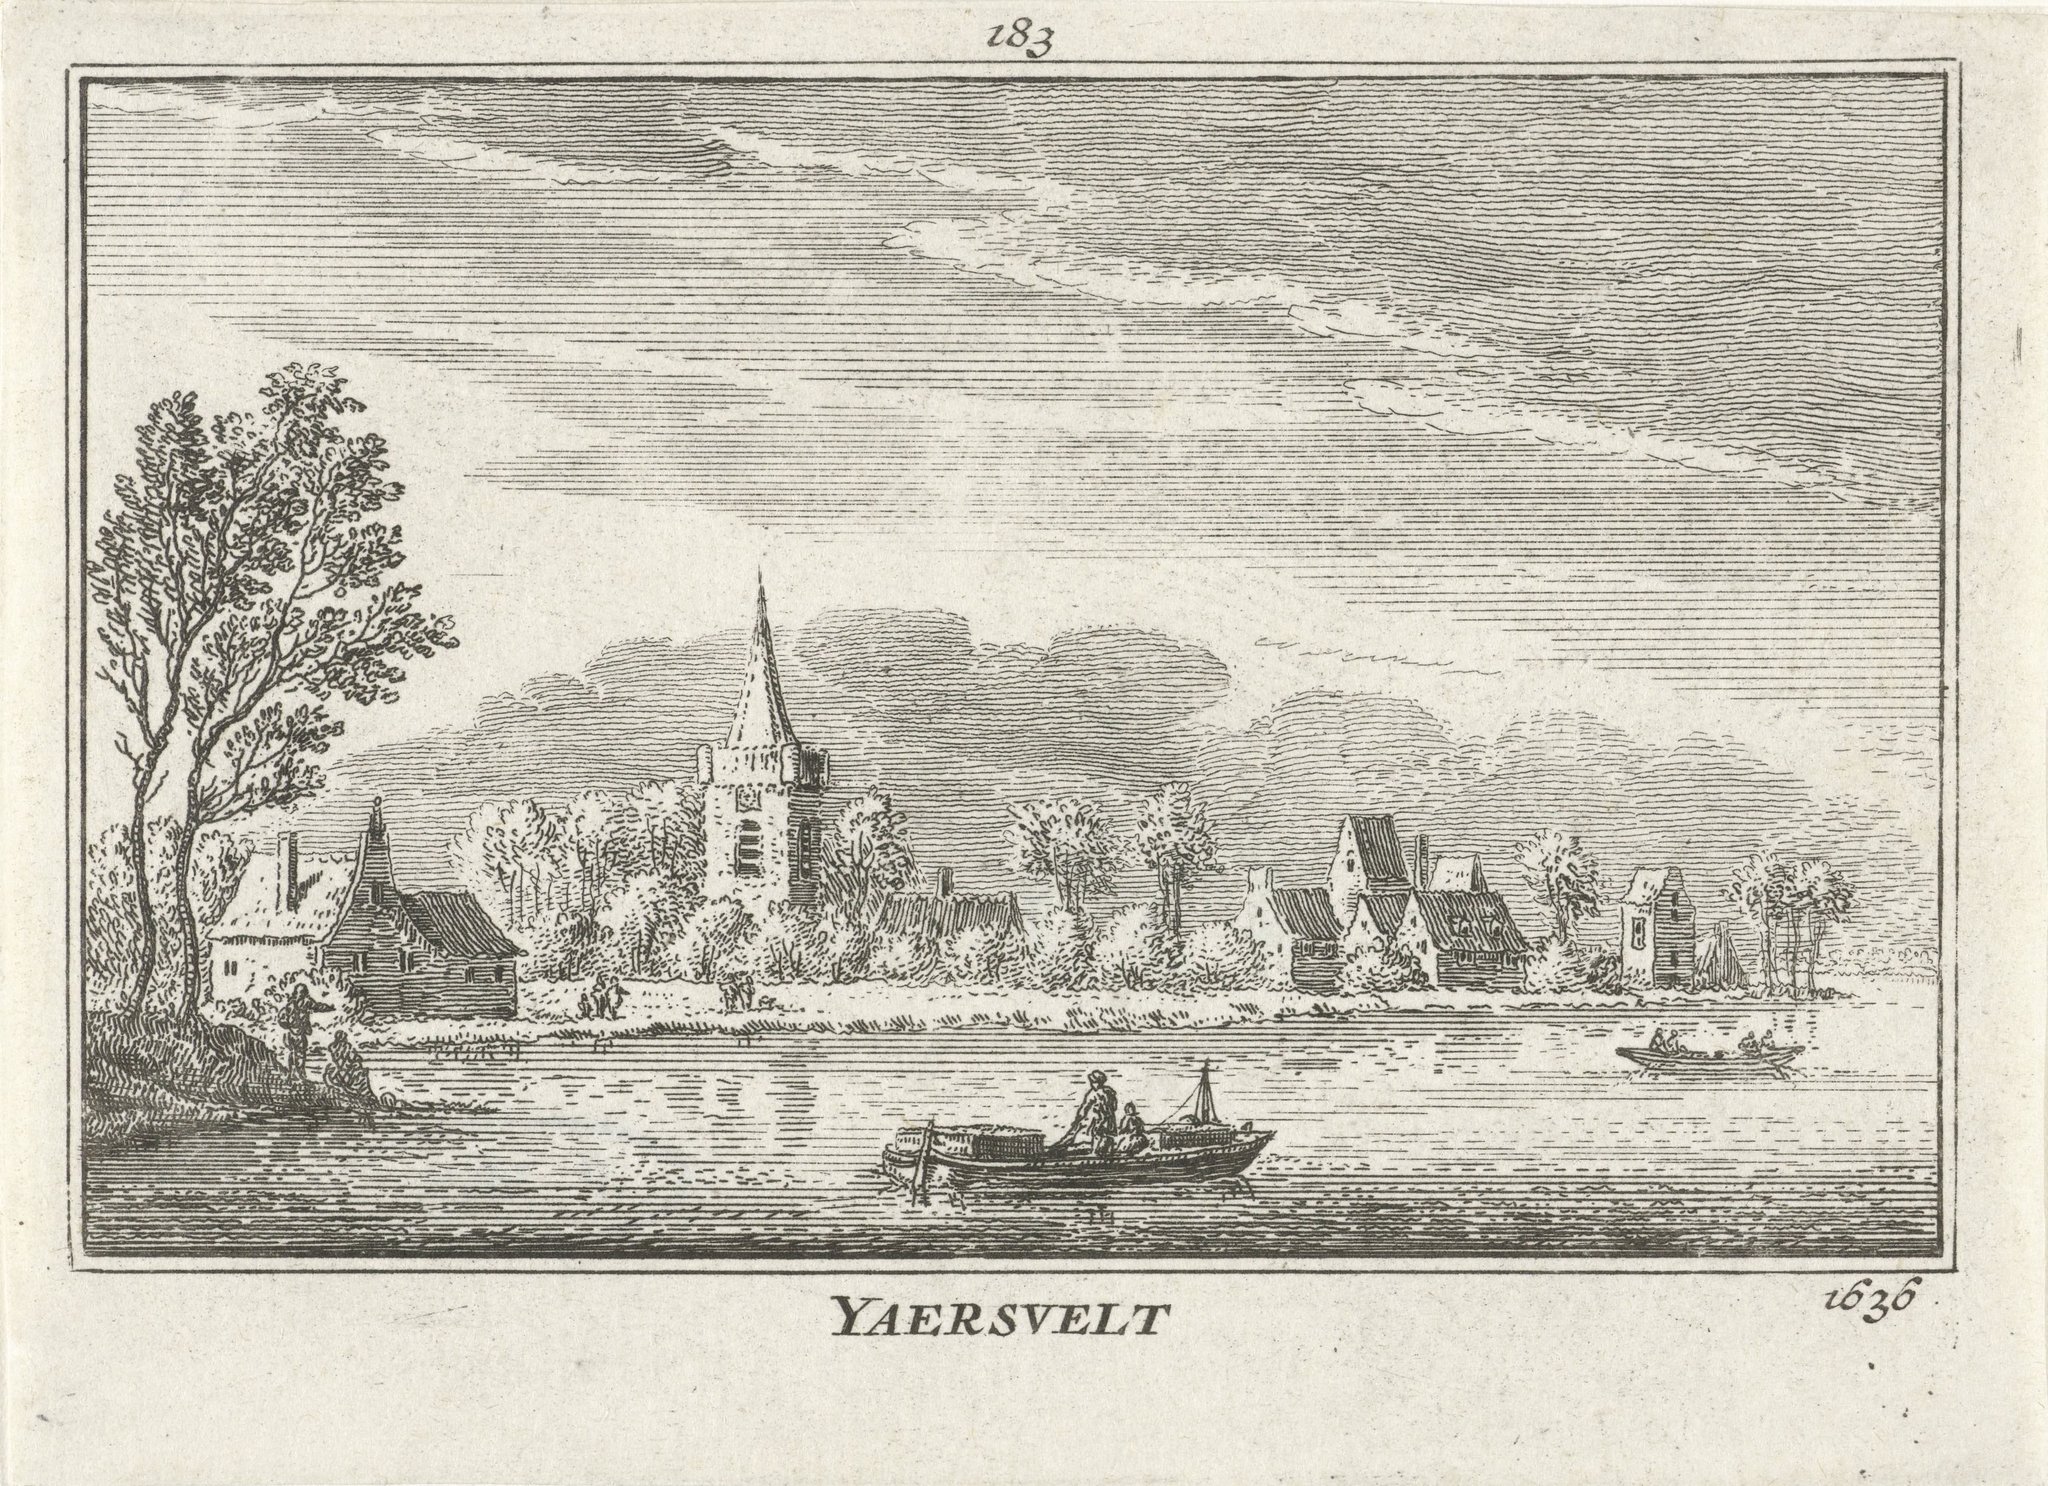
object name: book illustration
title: Gezicht op Jaarsveld, 1636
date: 1727-1733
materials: paper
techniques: etching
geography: amsterdam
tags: prospect of village, silhouette of village, church (exterior), rowing-boat, canoe, etc., jaarsveld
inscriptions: collector's mark: Lugt 2228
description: Illustratie uit: Abraham Rademaker, Matthaeus Brouërius van Niedek, Isaac Le Long, Kabinet van Nederlandsche en Kleefsche outheden en (...) voorname stads- en landgebouwen, Willem Barents en Antoni Schoonenburg: Amsterdam, 1727-1733, ill. nr. 183.